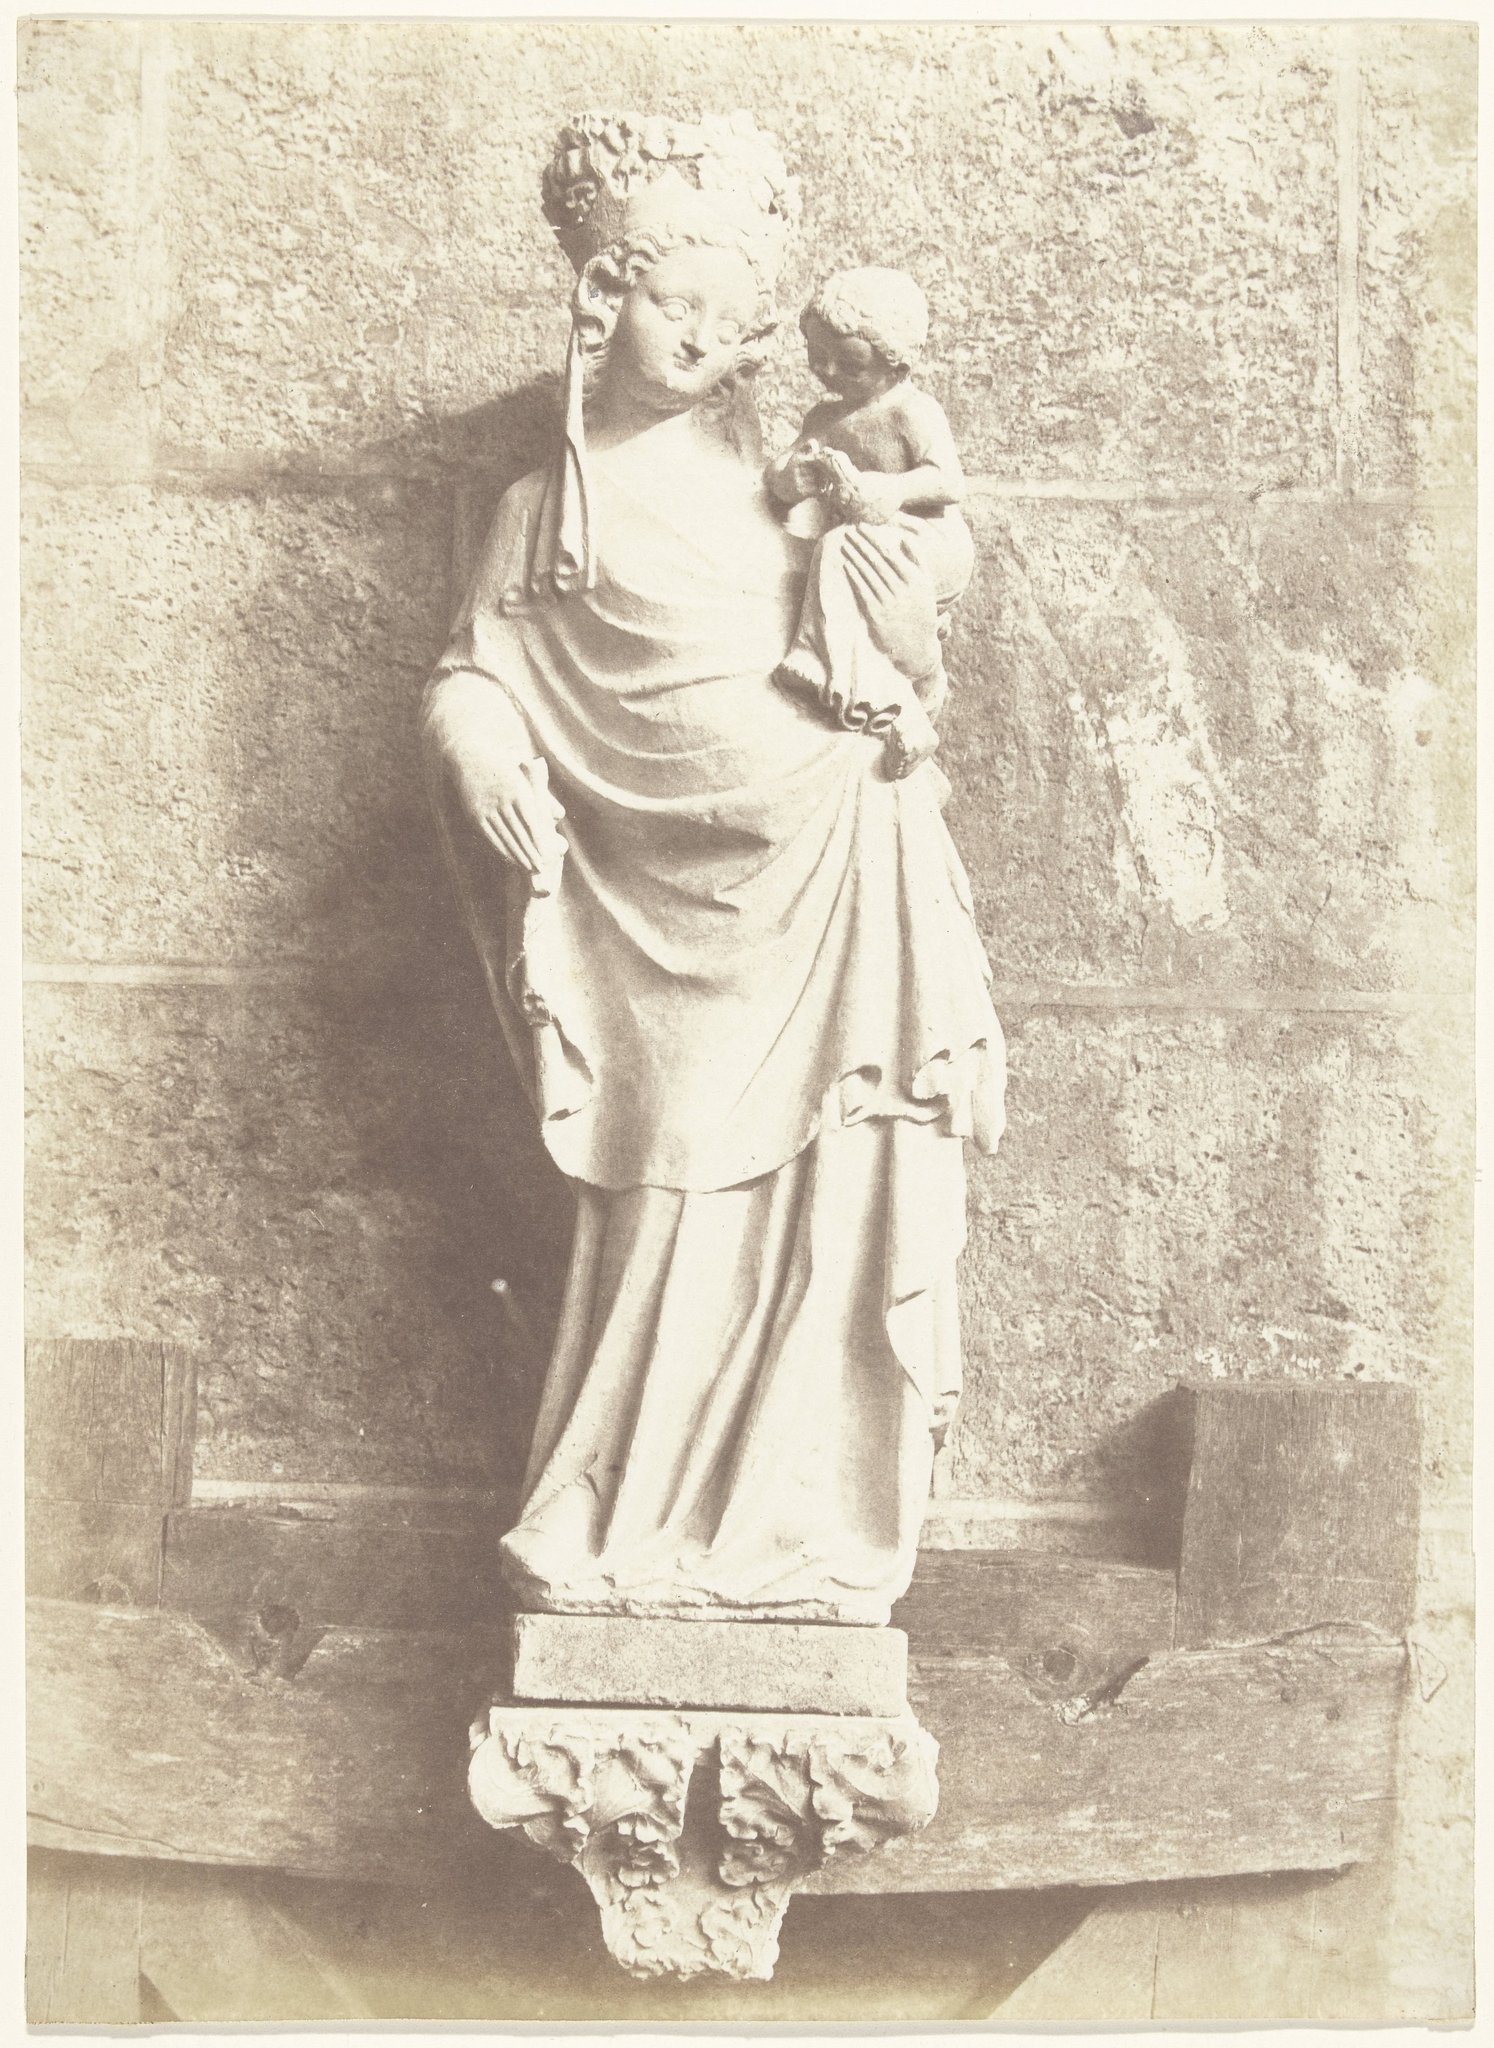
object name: photograph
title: Sculptuur van Maria met kind aan de Notre-Dame, Parijs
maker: charles nègre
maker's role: fotograaf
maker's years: 1820-1880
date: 1853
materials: paper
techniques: salted paper print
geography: paris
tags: mary standing (or half-length), the christ-child on her arm (christ-child to mary's left), sculpture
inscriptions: number: ‘544’